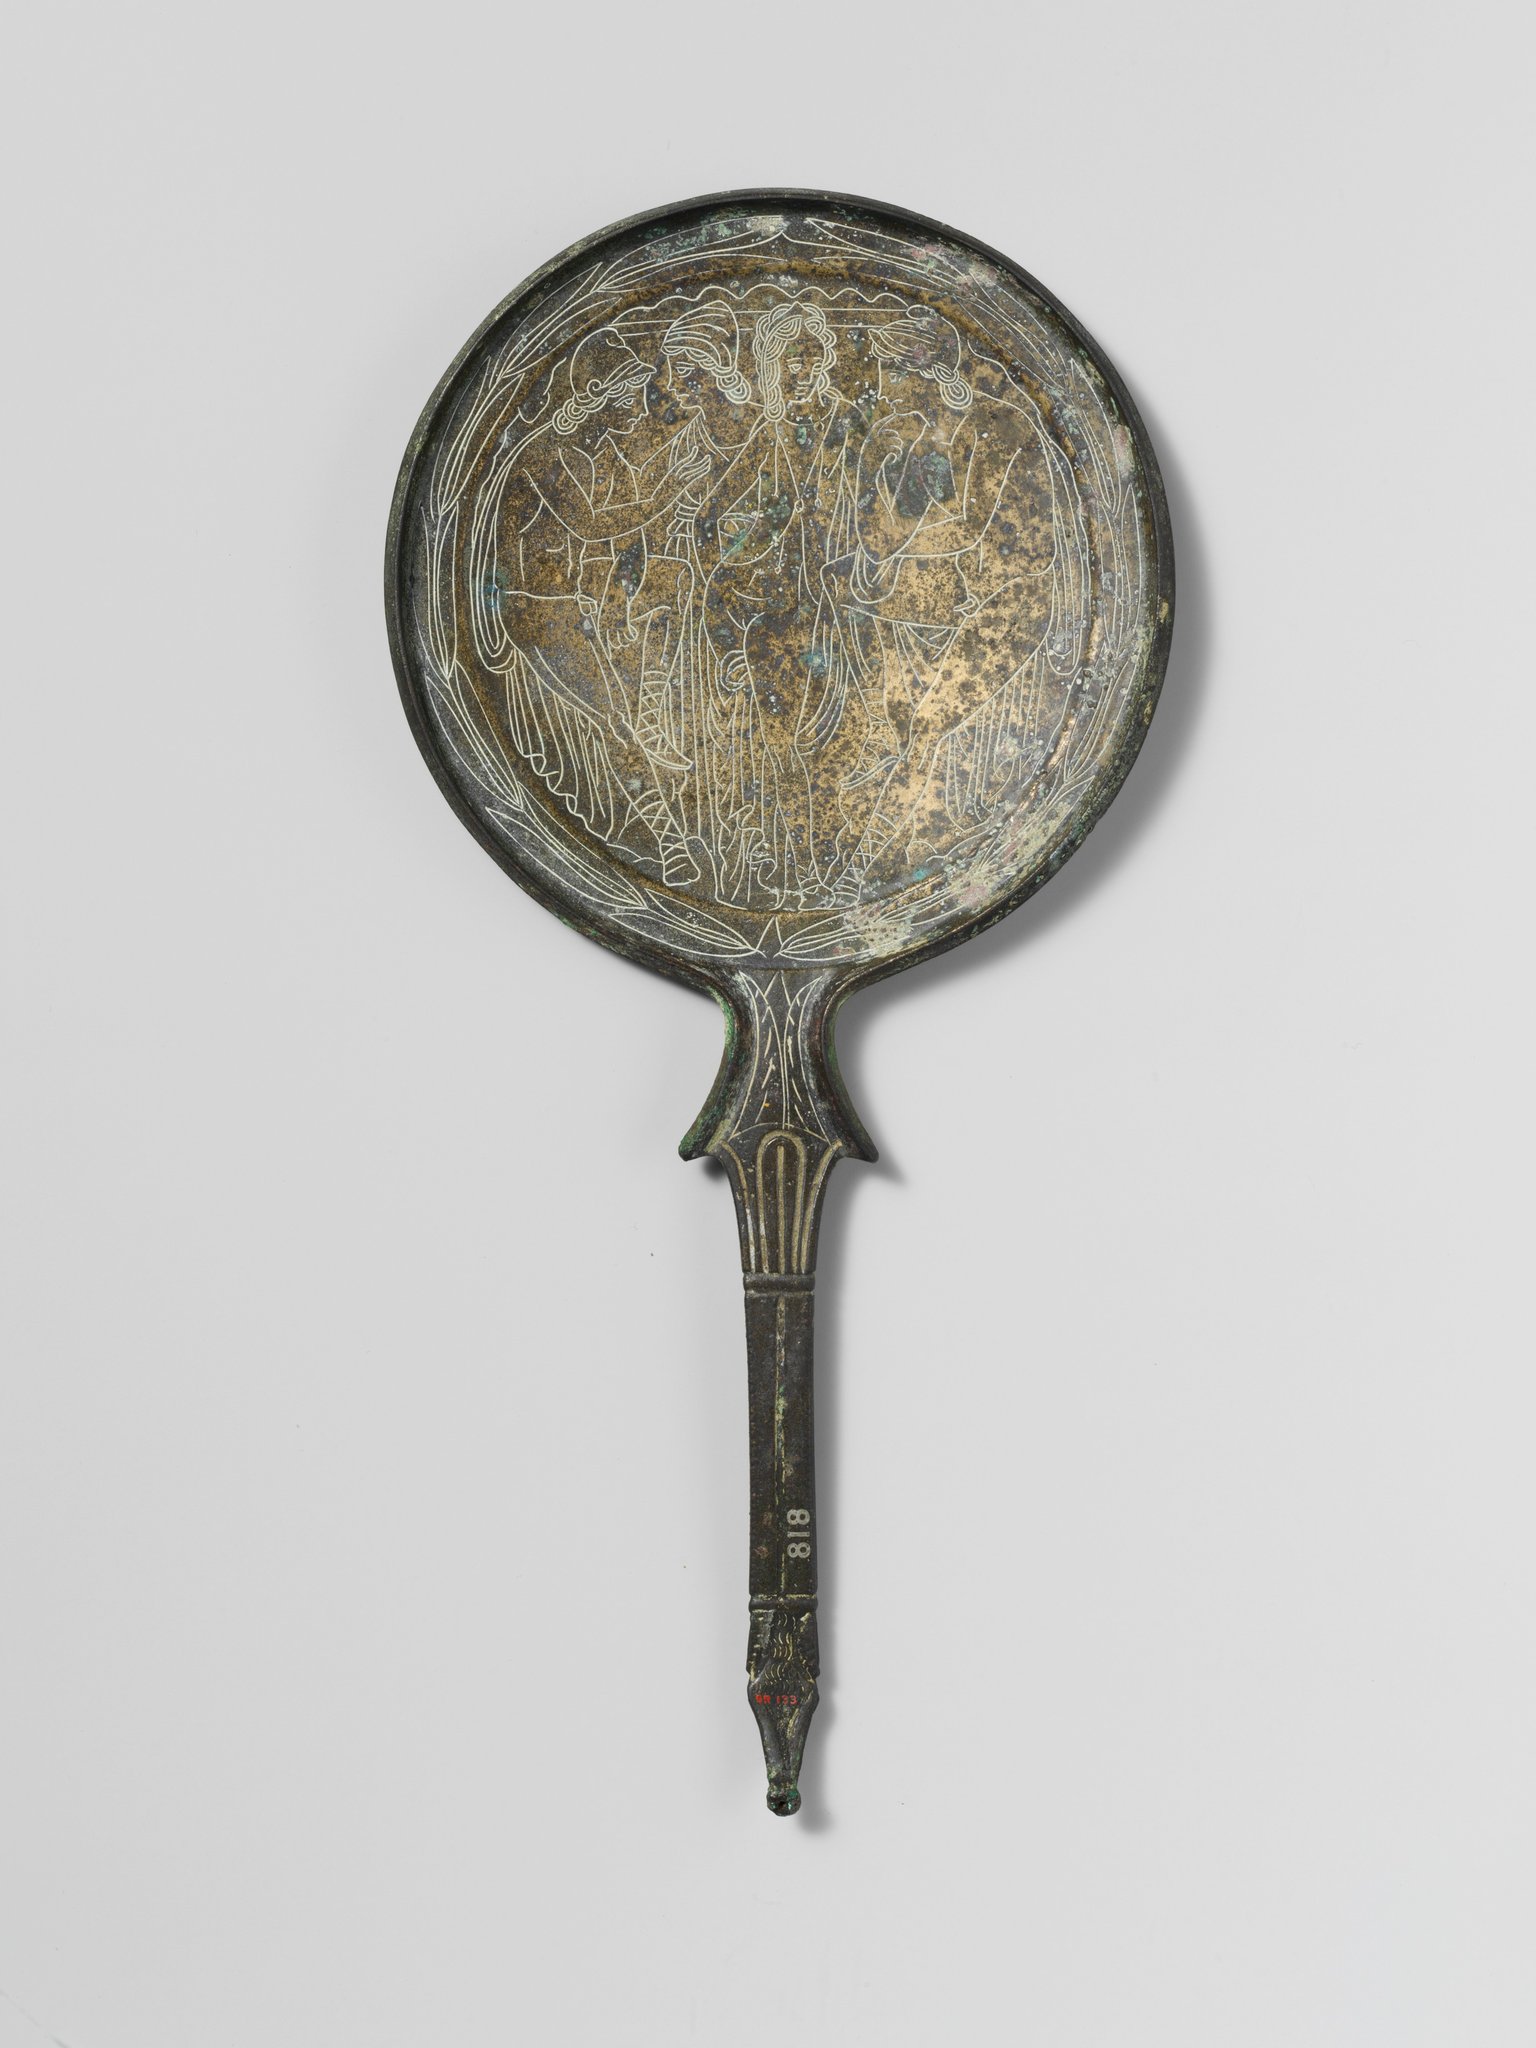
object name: mirror with castor and pollux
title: Bronze mirror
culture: etruscan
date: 250-200 BCE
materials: bronze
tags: men,women,female nudes